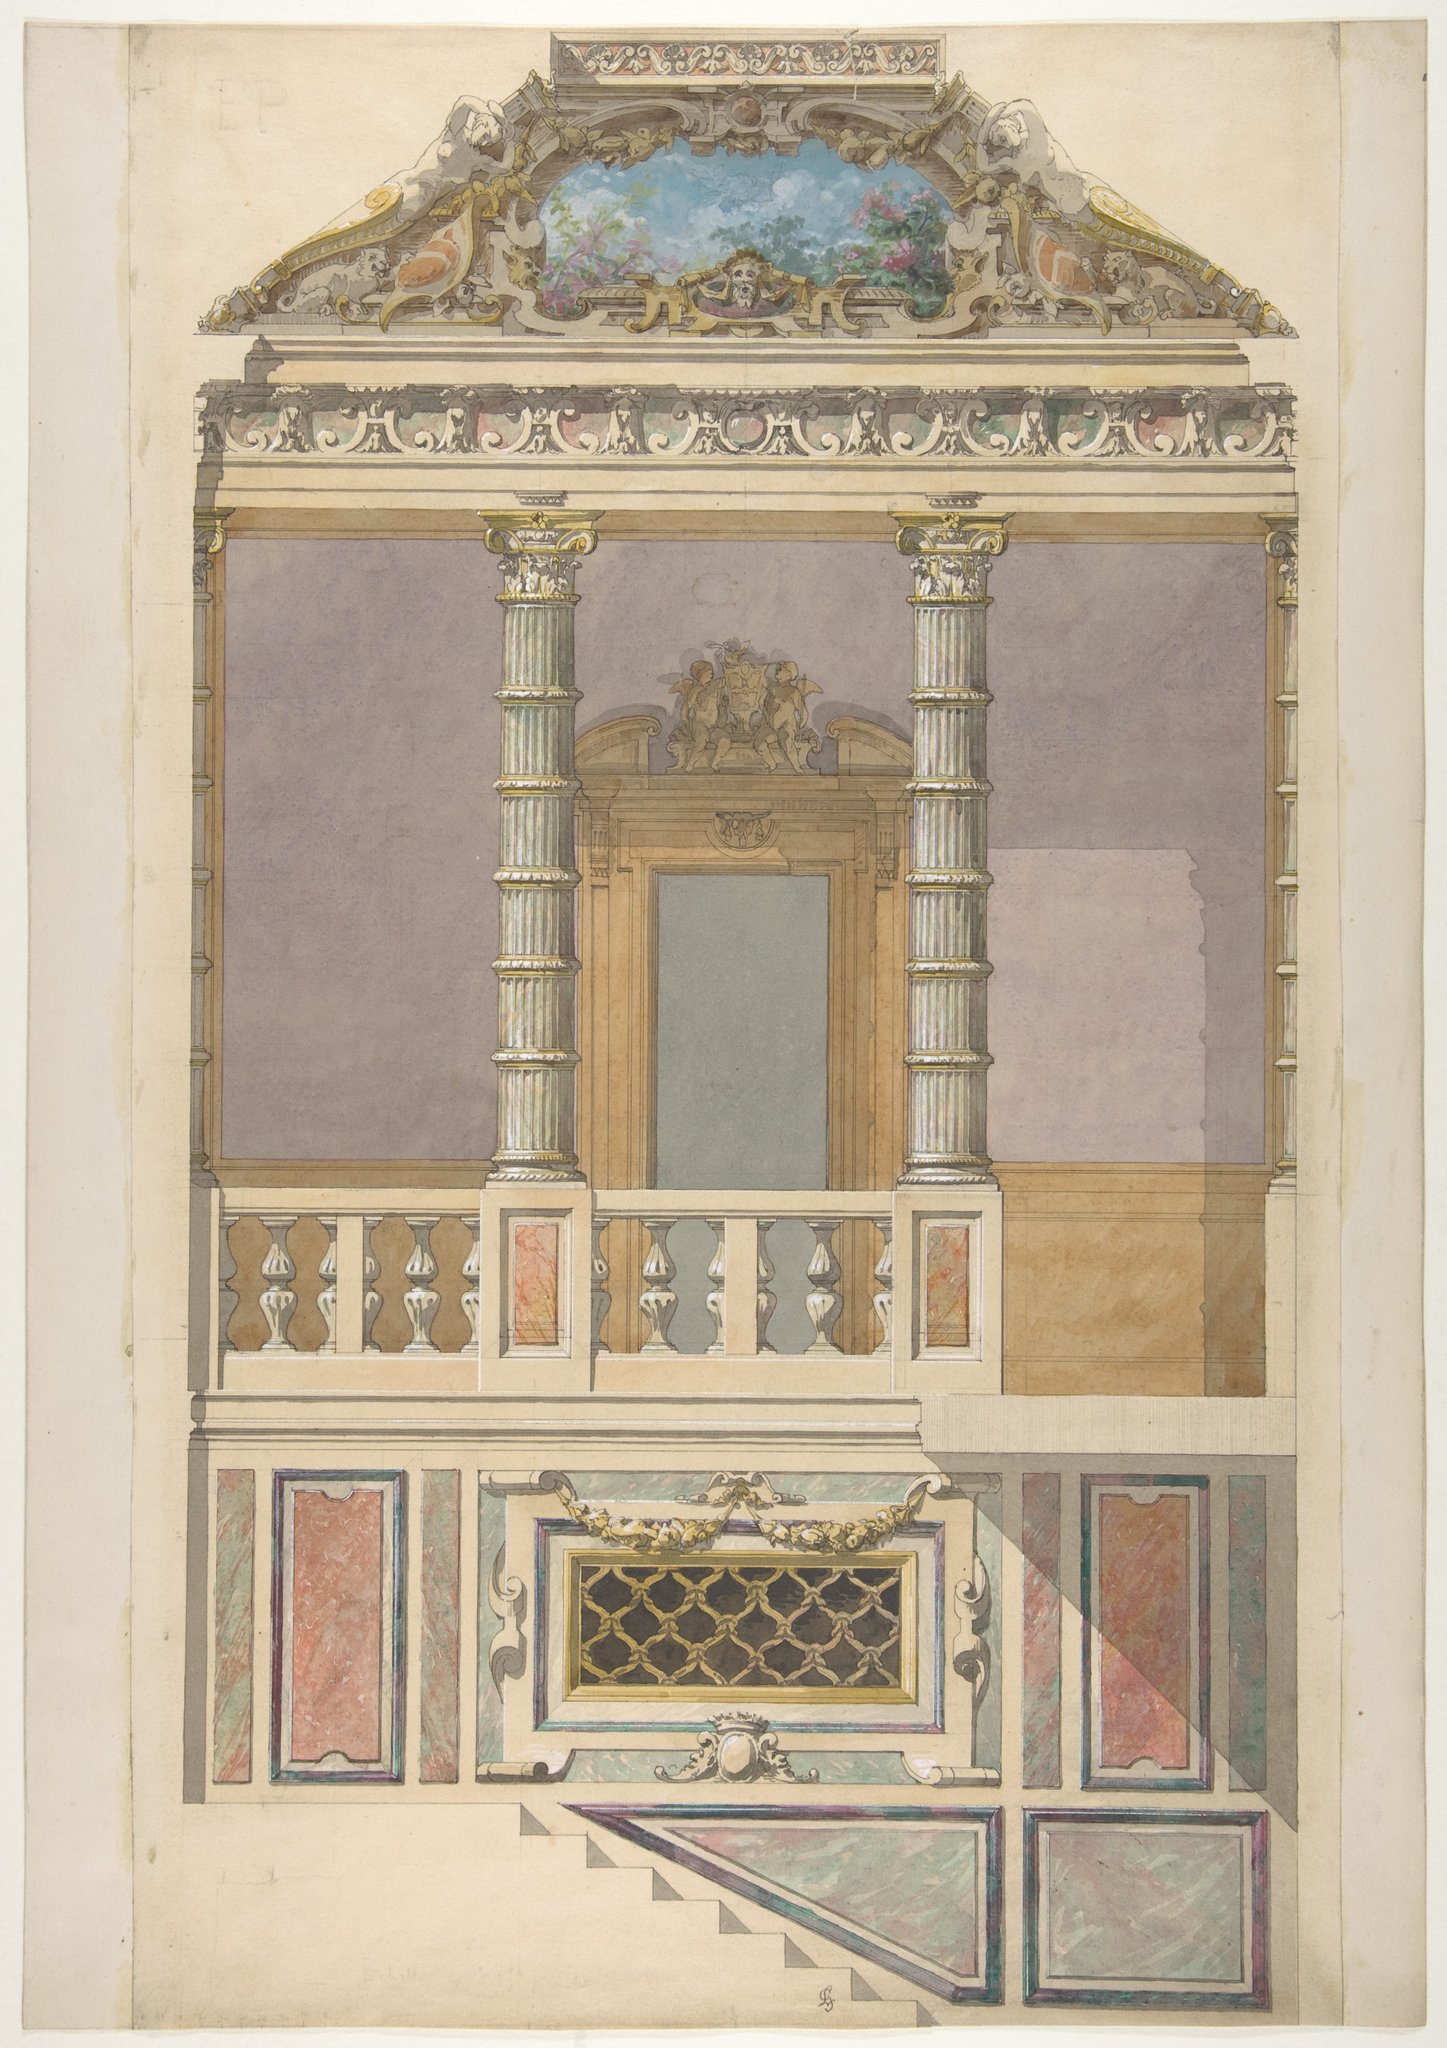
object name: drawing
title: Elevation of an Italianate interior, including steps and an upper loggia decorated in composite columns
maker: jules-edmond-charles lachaise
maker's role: artist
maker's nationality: french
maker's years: 1897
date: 1830-1897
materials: ink, watercolor, paper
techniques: heightening, pen, wash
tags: columns,stairs,interiors